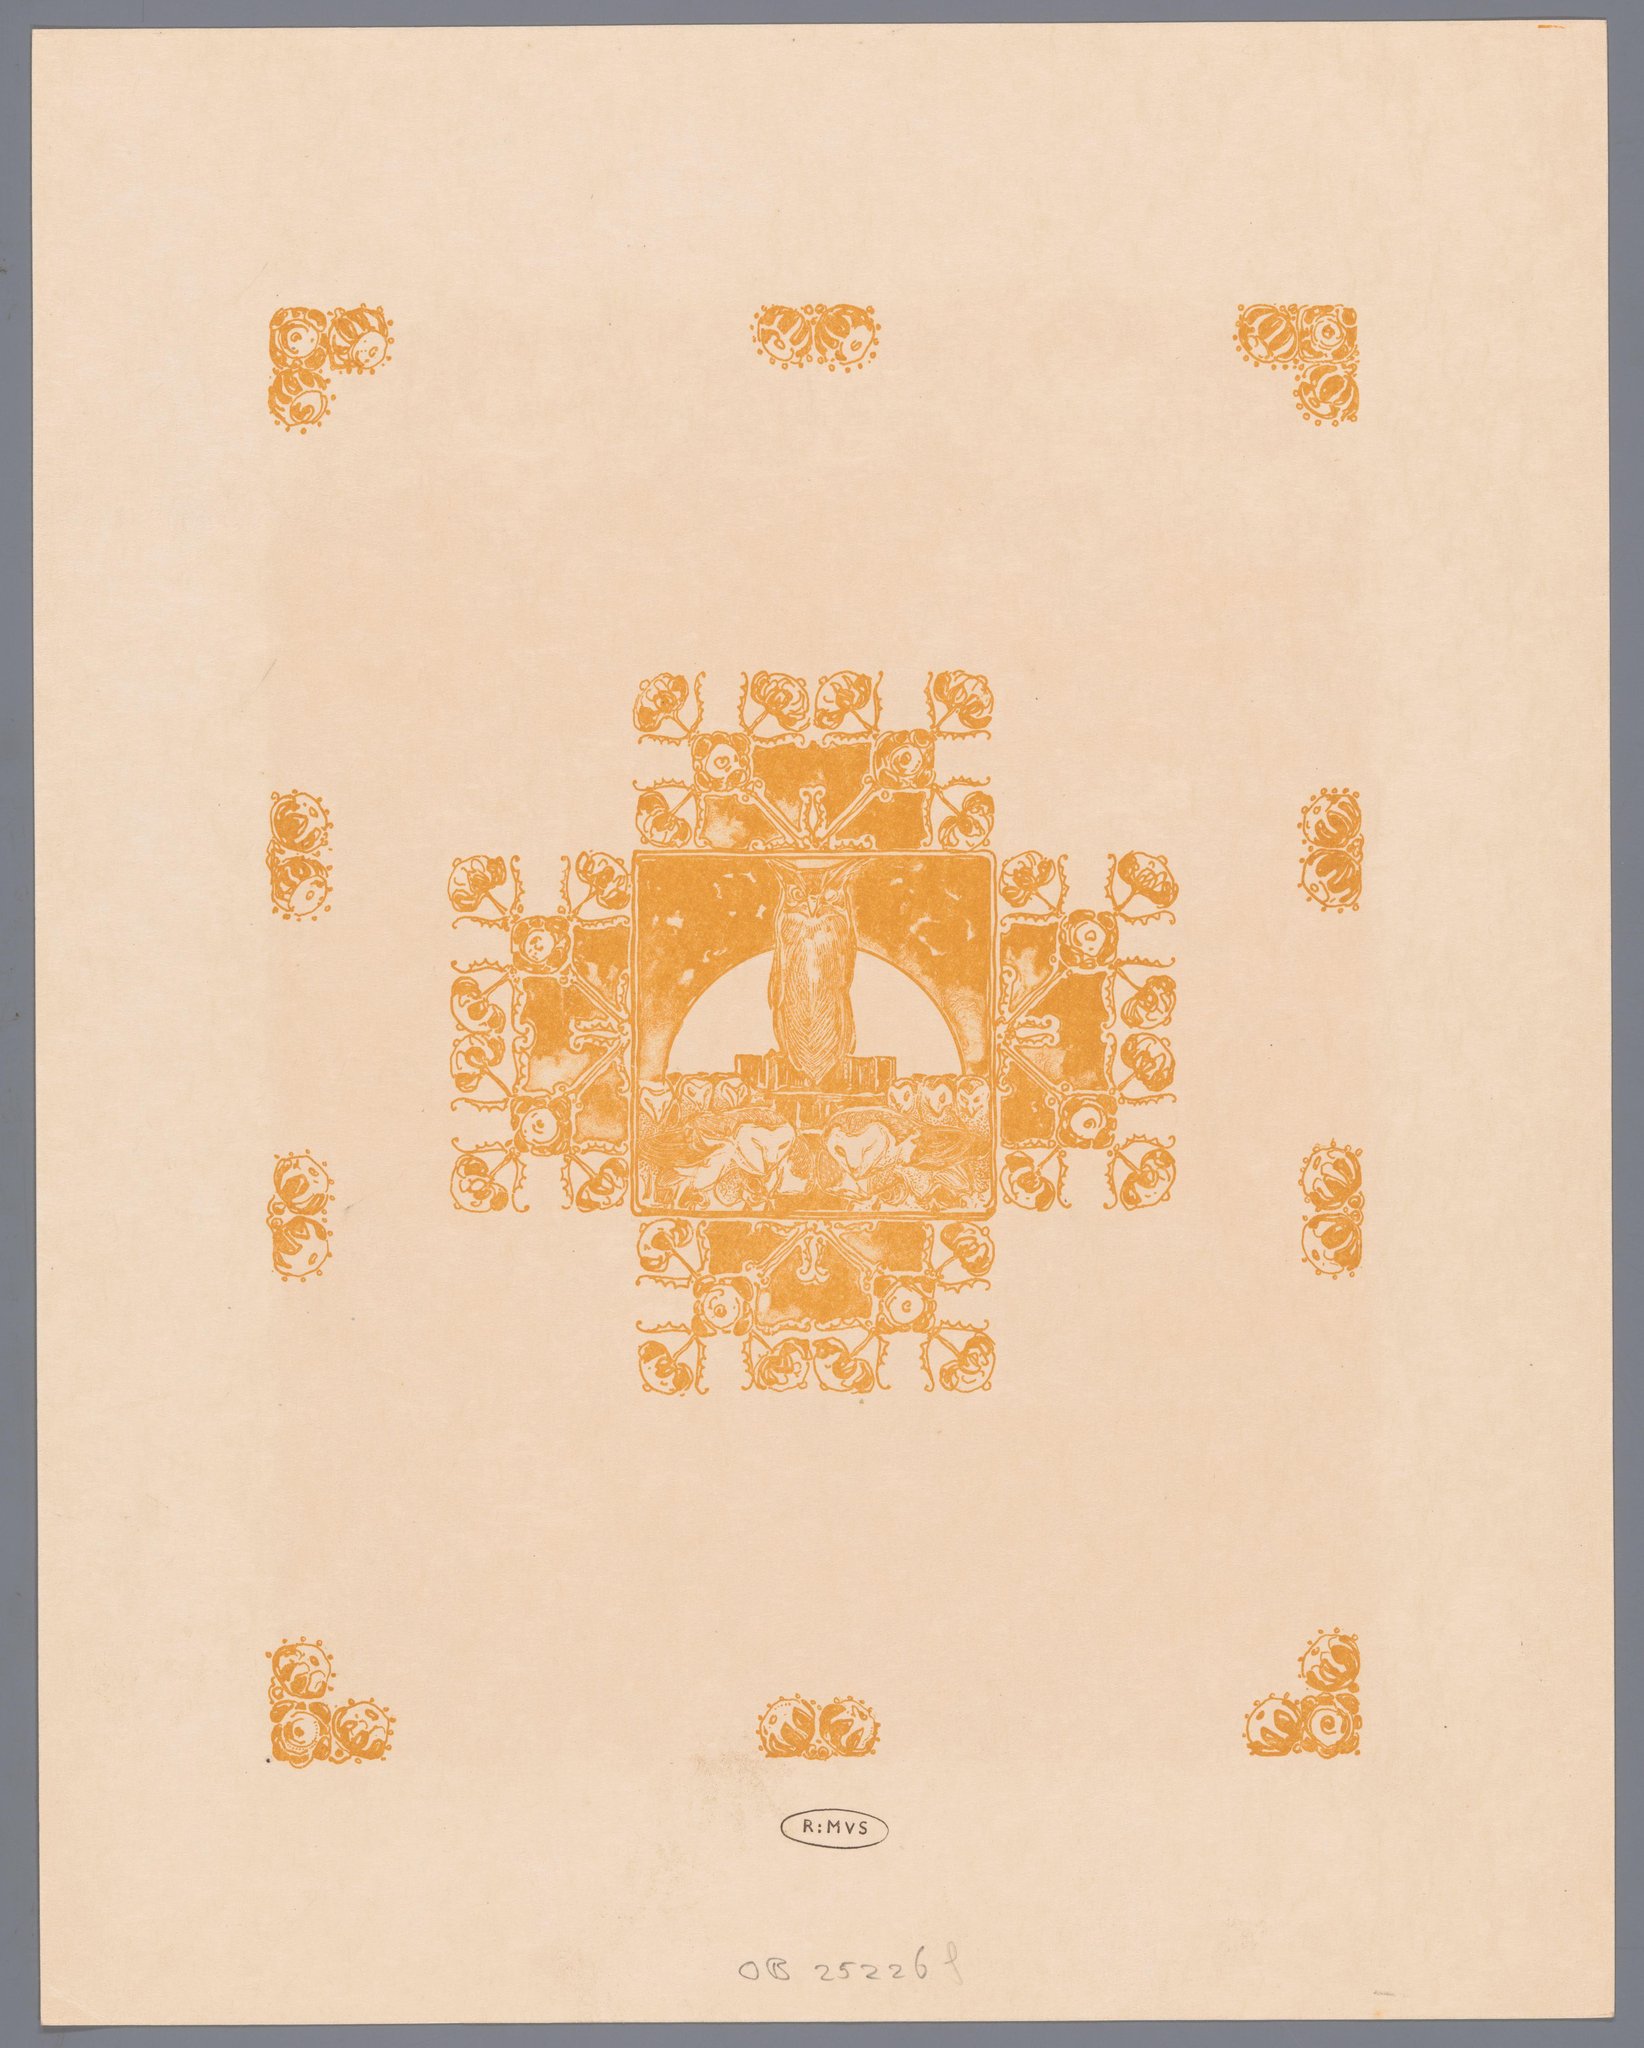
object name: print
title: Ornamentiek en uilen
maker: bernard willem wierink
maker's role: draughtsman, print maker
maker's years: 1856-1939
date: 1910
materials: paper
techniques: lithograph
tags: fable of reynard the fox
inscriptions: collector's mark: Lugt 2228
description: Prent gebruikt in: Streuvels, Stijn (Frank Lateur). Reinaert de Vos naar verschillende uitgaven van het middeleeuwsche epos. Amsterdam: L.J. Veen, 1910.